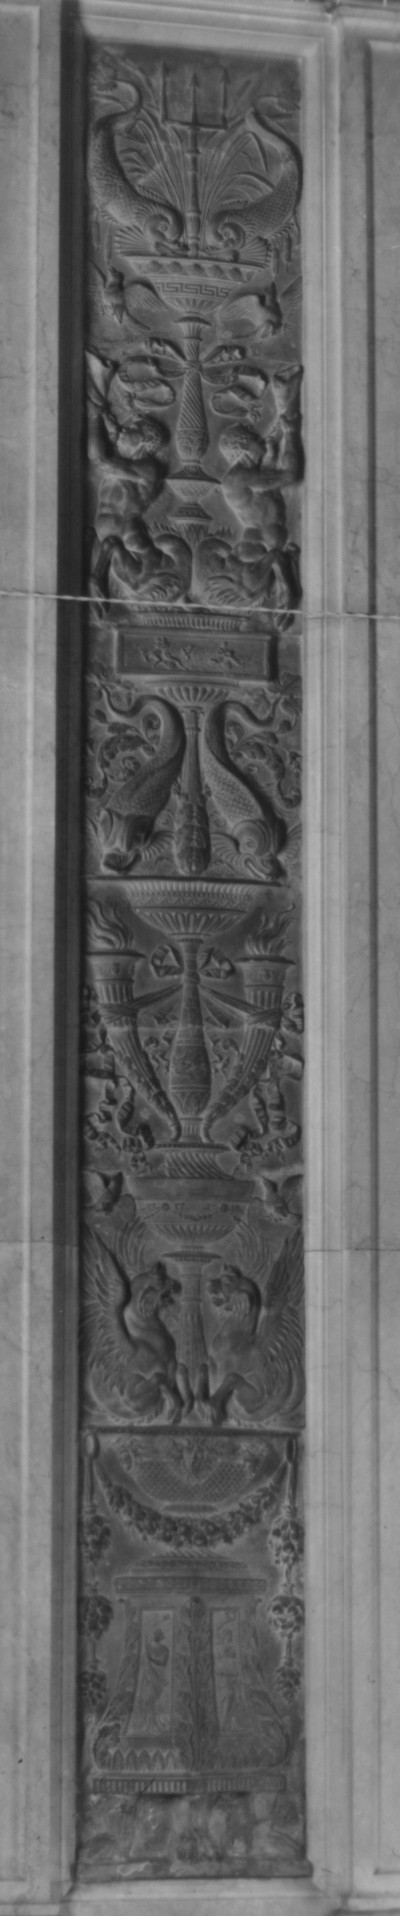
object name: pilaster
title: Pilaster (one of four)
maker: graziani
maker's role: artist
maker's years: 1762-1835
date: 1767-1833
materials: terracotta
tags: griffins,dolphins